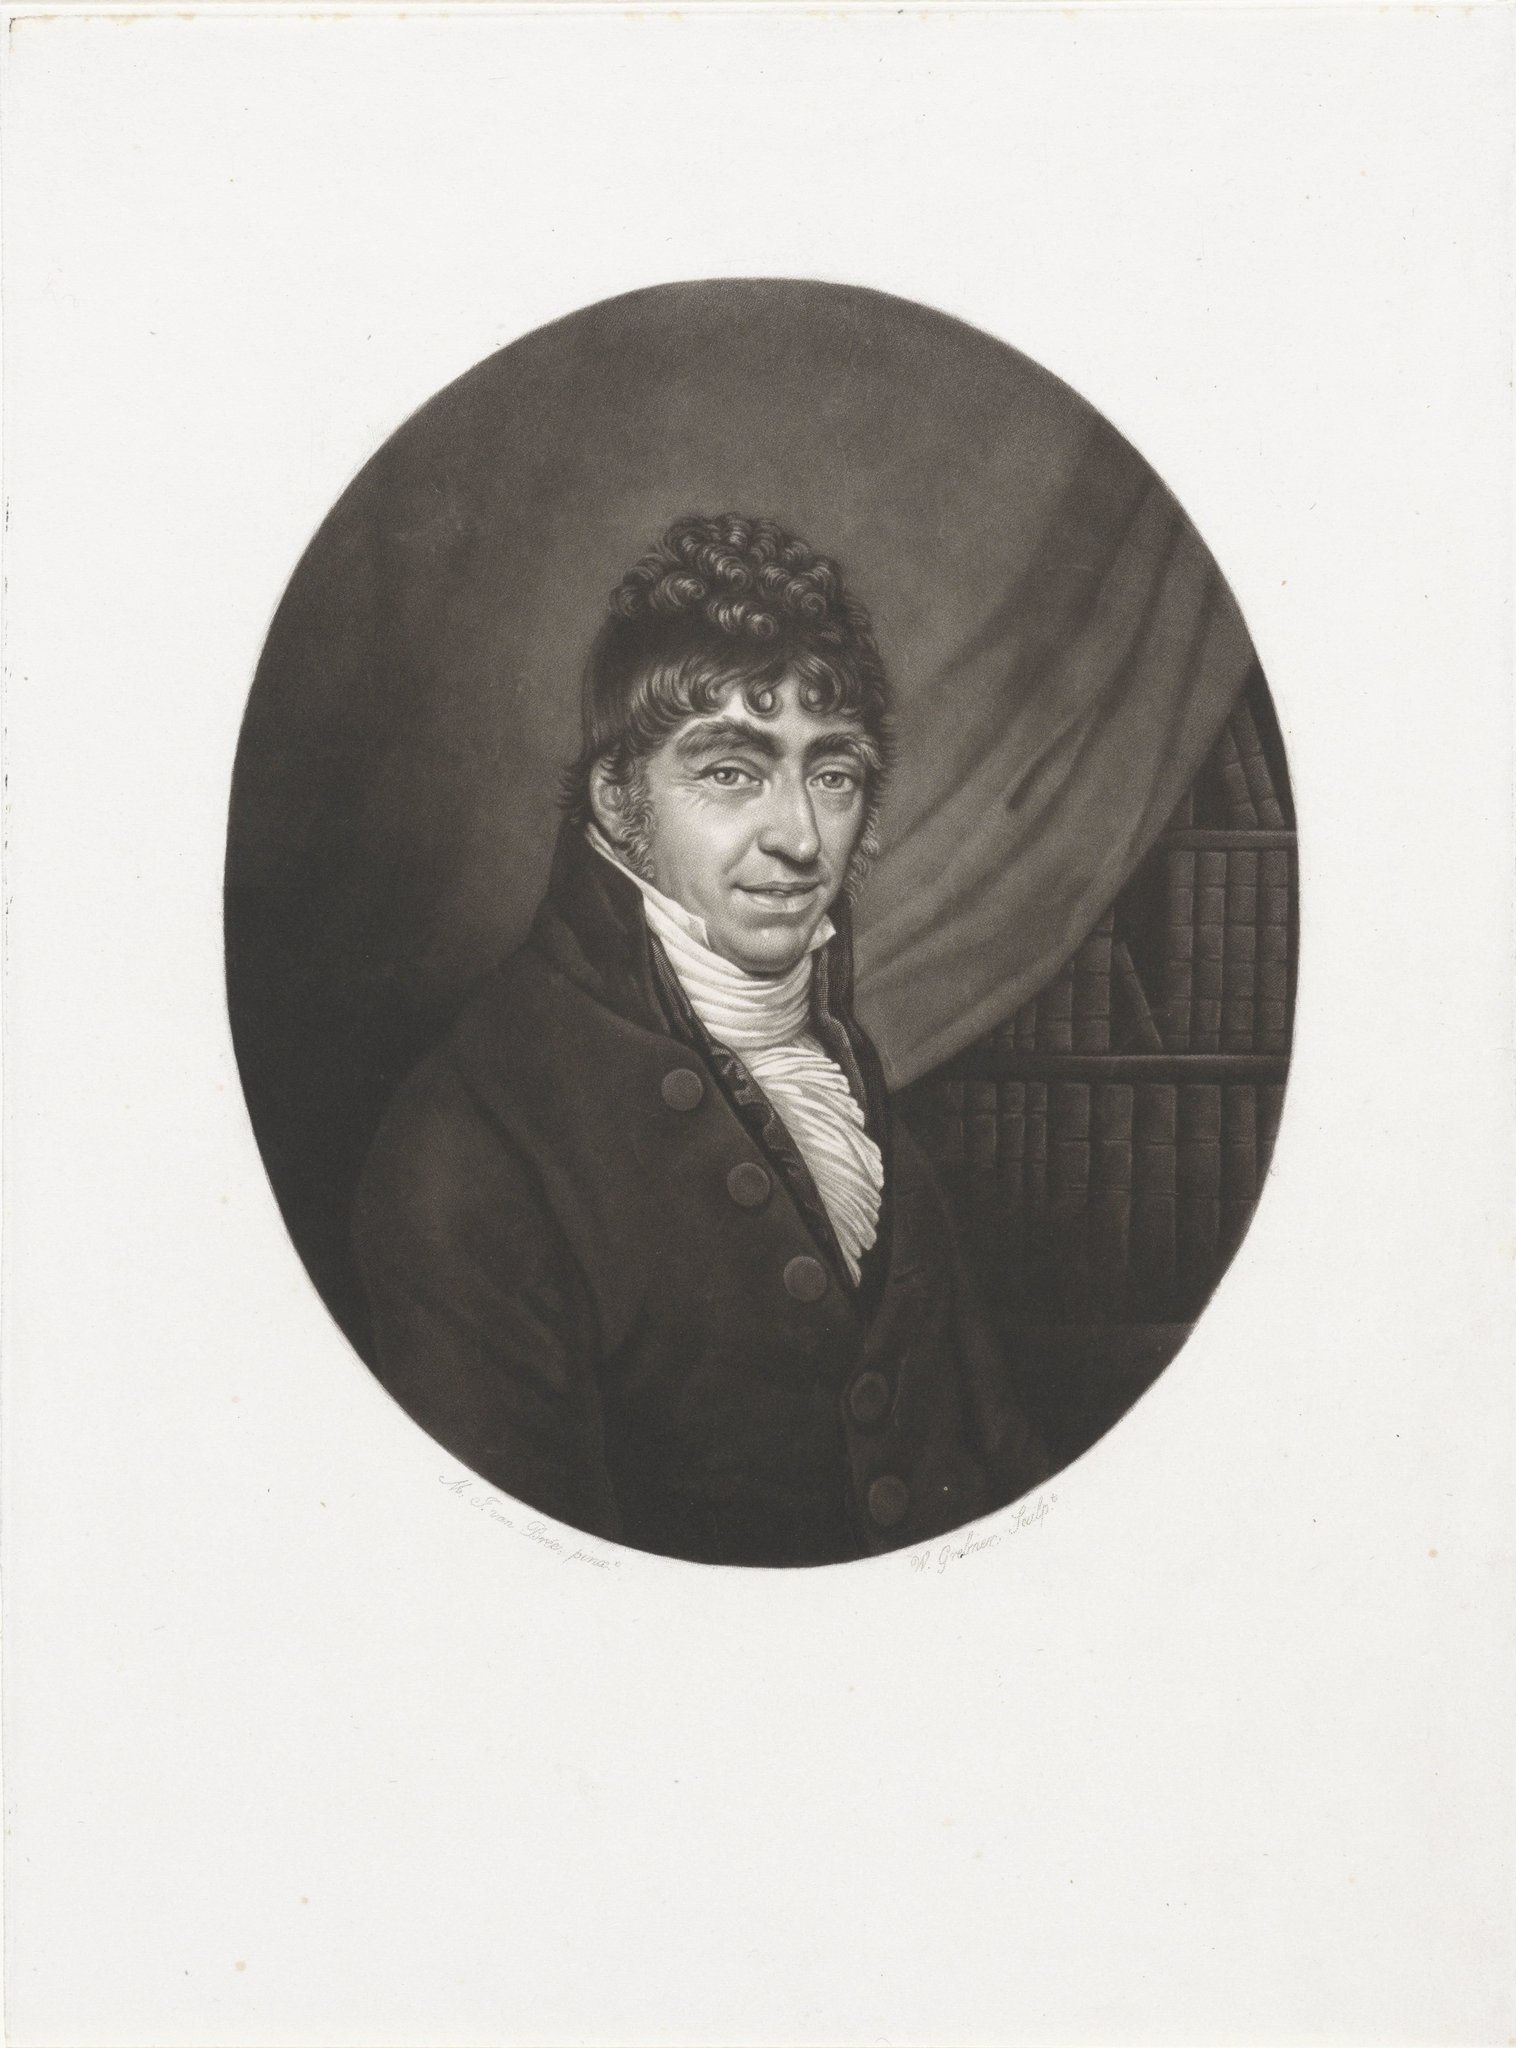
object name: print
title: Portret van Willem Bilderdijk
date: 1794-1866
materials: paper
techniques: roulette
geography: amsterdam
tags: amsterdam, haarlem, print maker, draughtsman, willem bilderdijk, book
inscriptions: collector's mark: Lugt 2228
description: De geschiedschrijver, taalkundige, dichter en advocaat Willem Bilderdijk. Op de achtergrond een boekenkast.